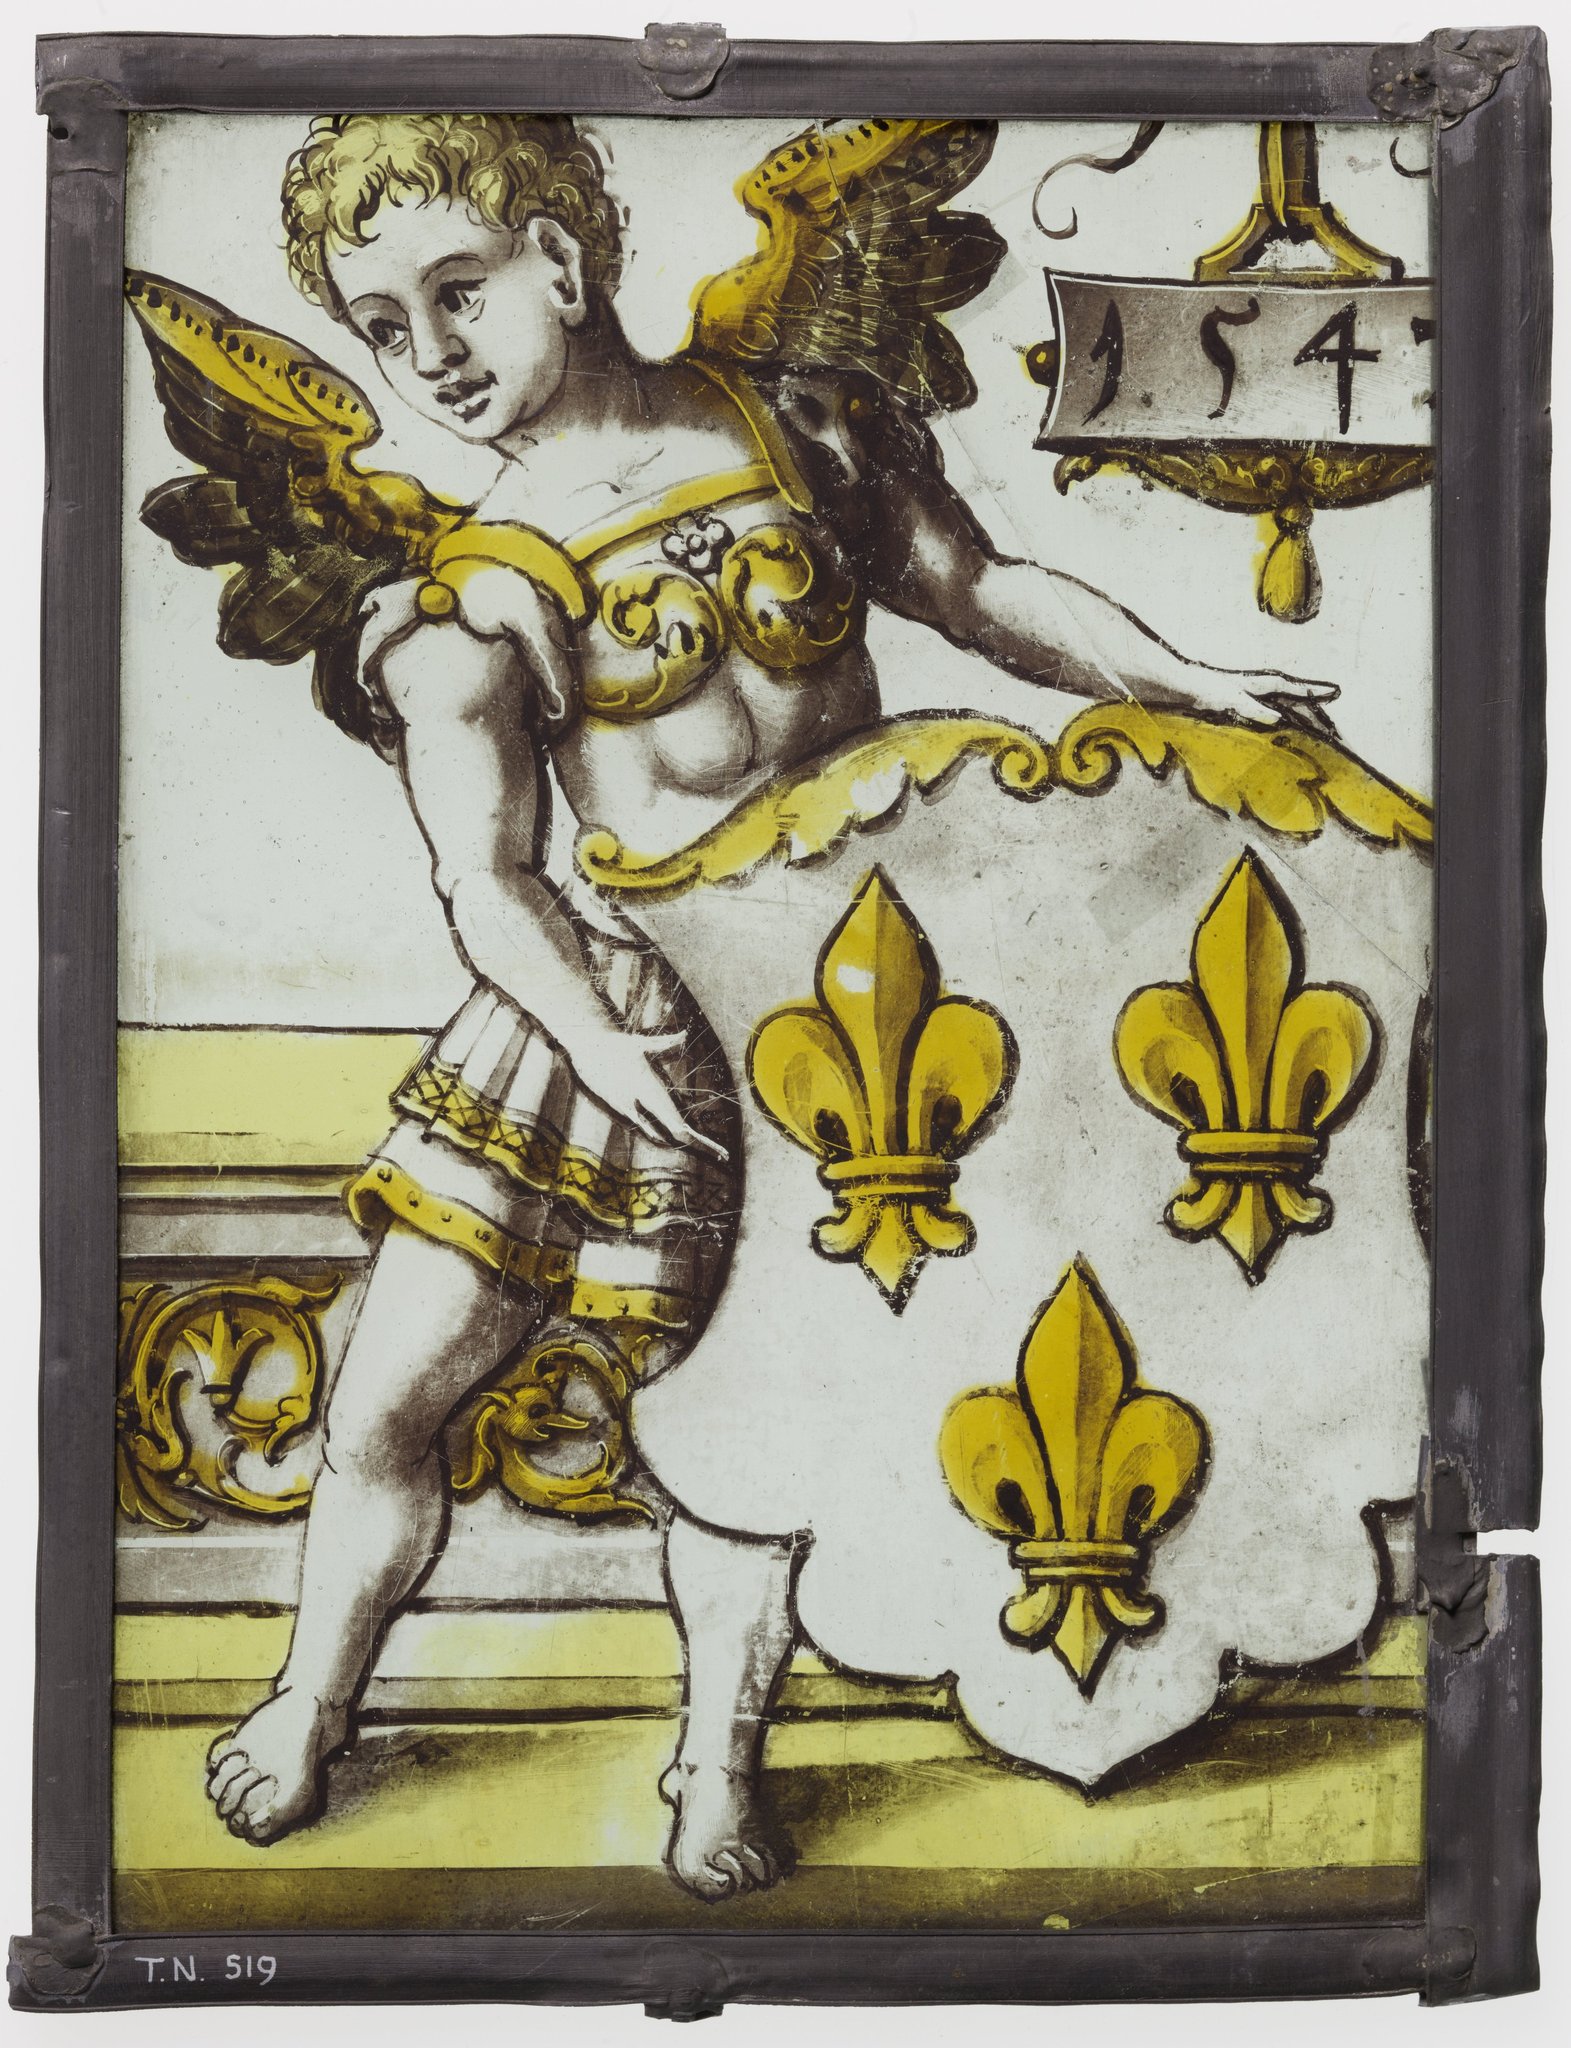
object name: light window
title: Ruit met jongeman met vleugels met wapenschild in de hand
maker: Anonymous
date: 1547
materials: glass, lead, pigment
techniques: leading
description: Rechthoekige ruit in grisaille en zilvergeel met een wapendragertje; een jonge man met vleugels, die een wapenschild in zijn handen heeft.